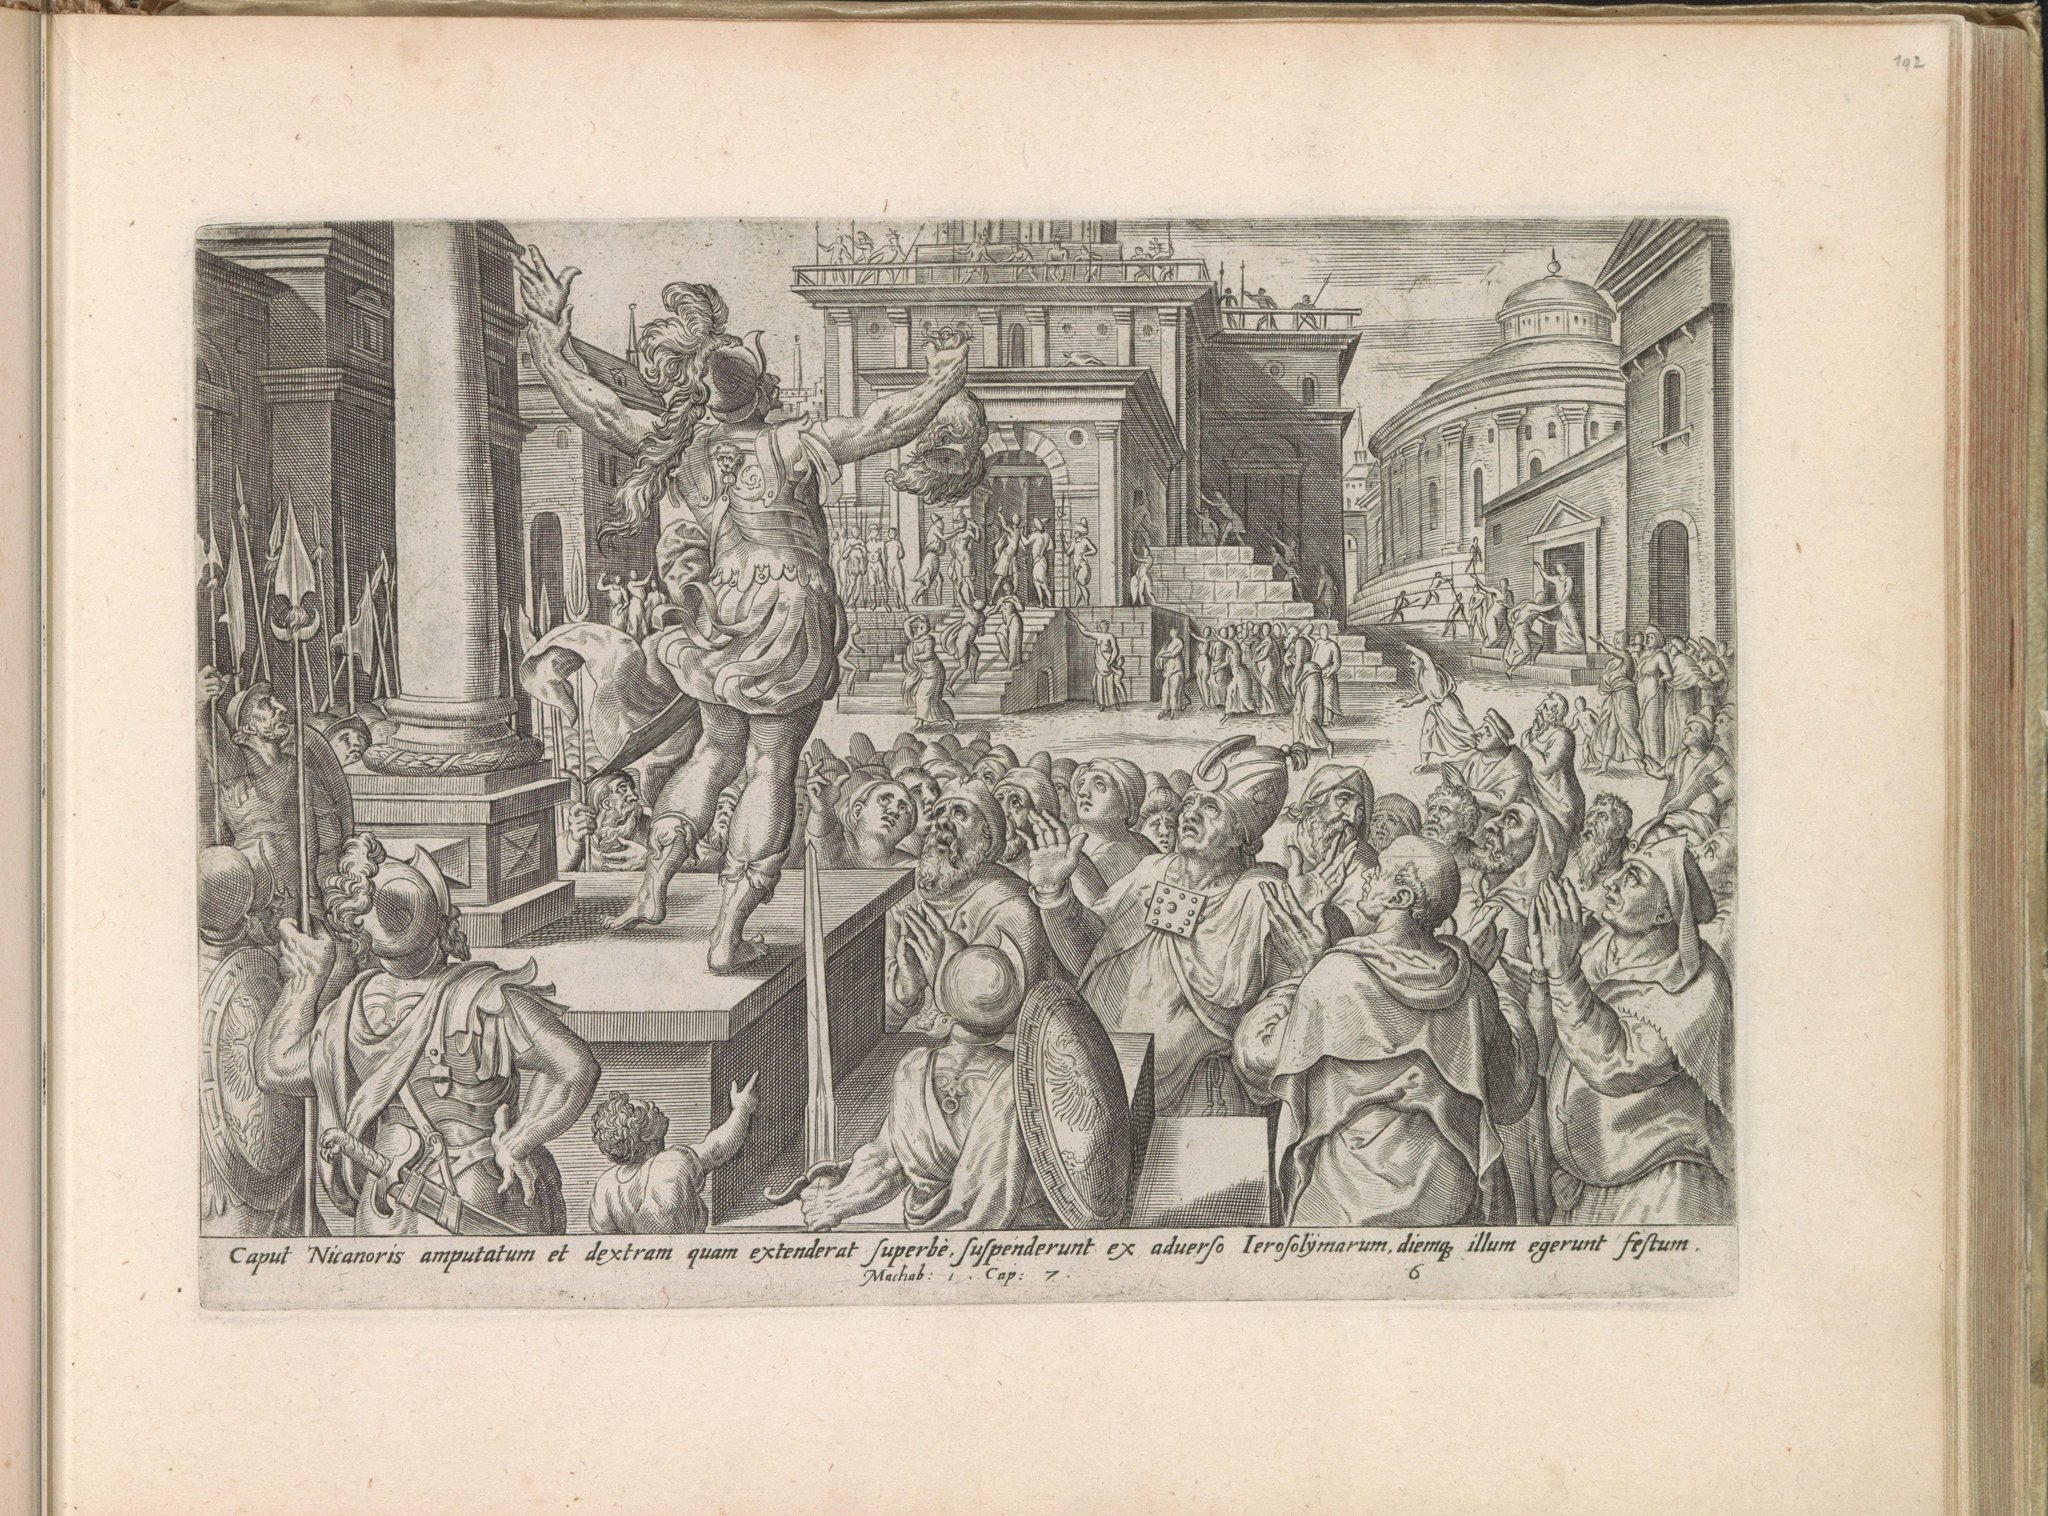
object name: album leaf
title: Thesaurus sacrarum historiaru[m] veteris testame[n]ti, elega[n]tissimis imaginibus expressu[m] excelle[n]tissimoru[m] in hac arte viroru[m] opera: nu[n]c primu[m] in luce[m] editus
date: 1585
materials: paper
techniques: engraving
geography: antwerp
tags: nicanor's head and hand hung near jerusalem (+ variant)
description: Het afgehakte hoofd en de hand van Nikanor worden in Jeruzalem aan het volk getoond. Nikanor wilde Israël uitroeien, maar de Israëlieten overwonnen hem en zijn leger. Onder de voorstelling een verwijzing in het Latijn naar de Bijbeltekst in 1 Makk. 7:27. Deze prent maakt deel uit van een album.